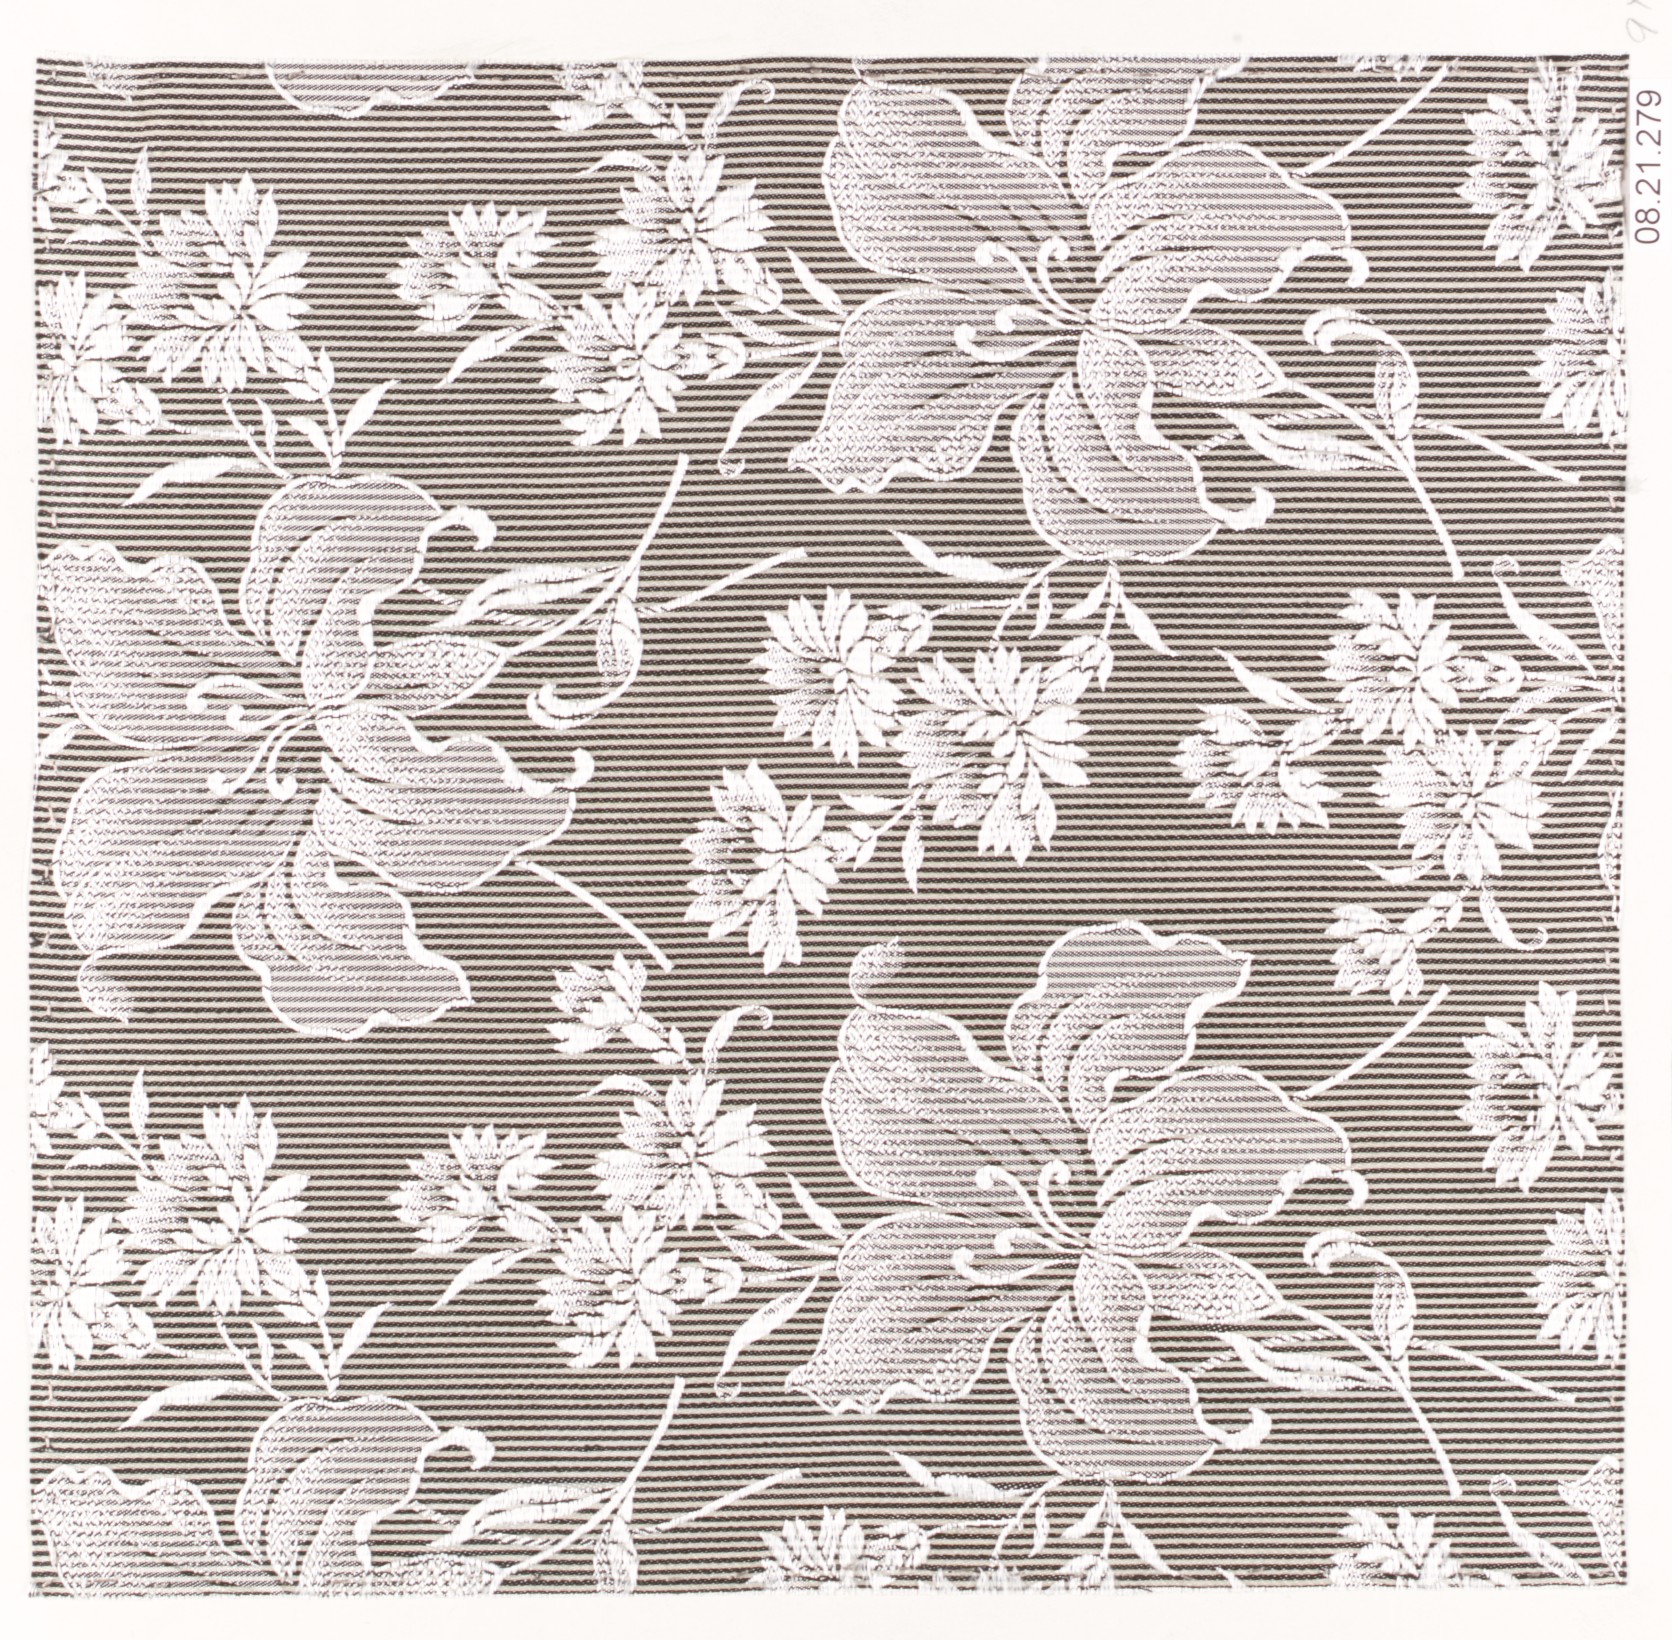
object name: textile sample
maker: Anonymous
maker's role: designer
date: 1900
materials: silk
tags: flowers